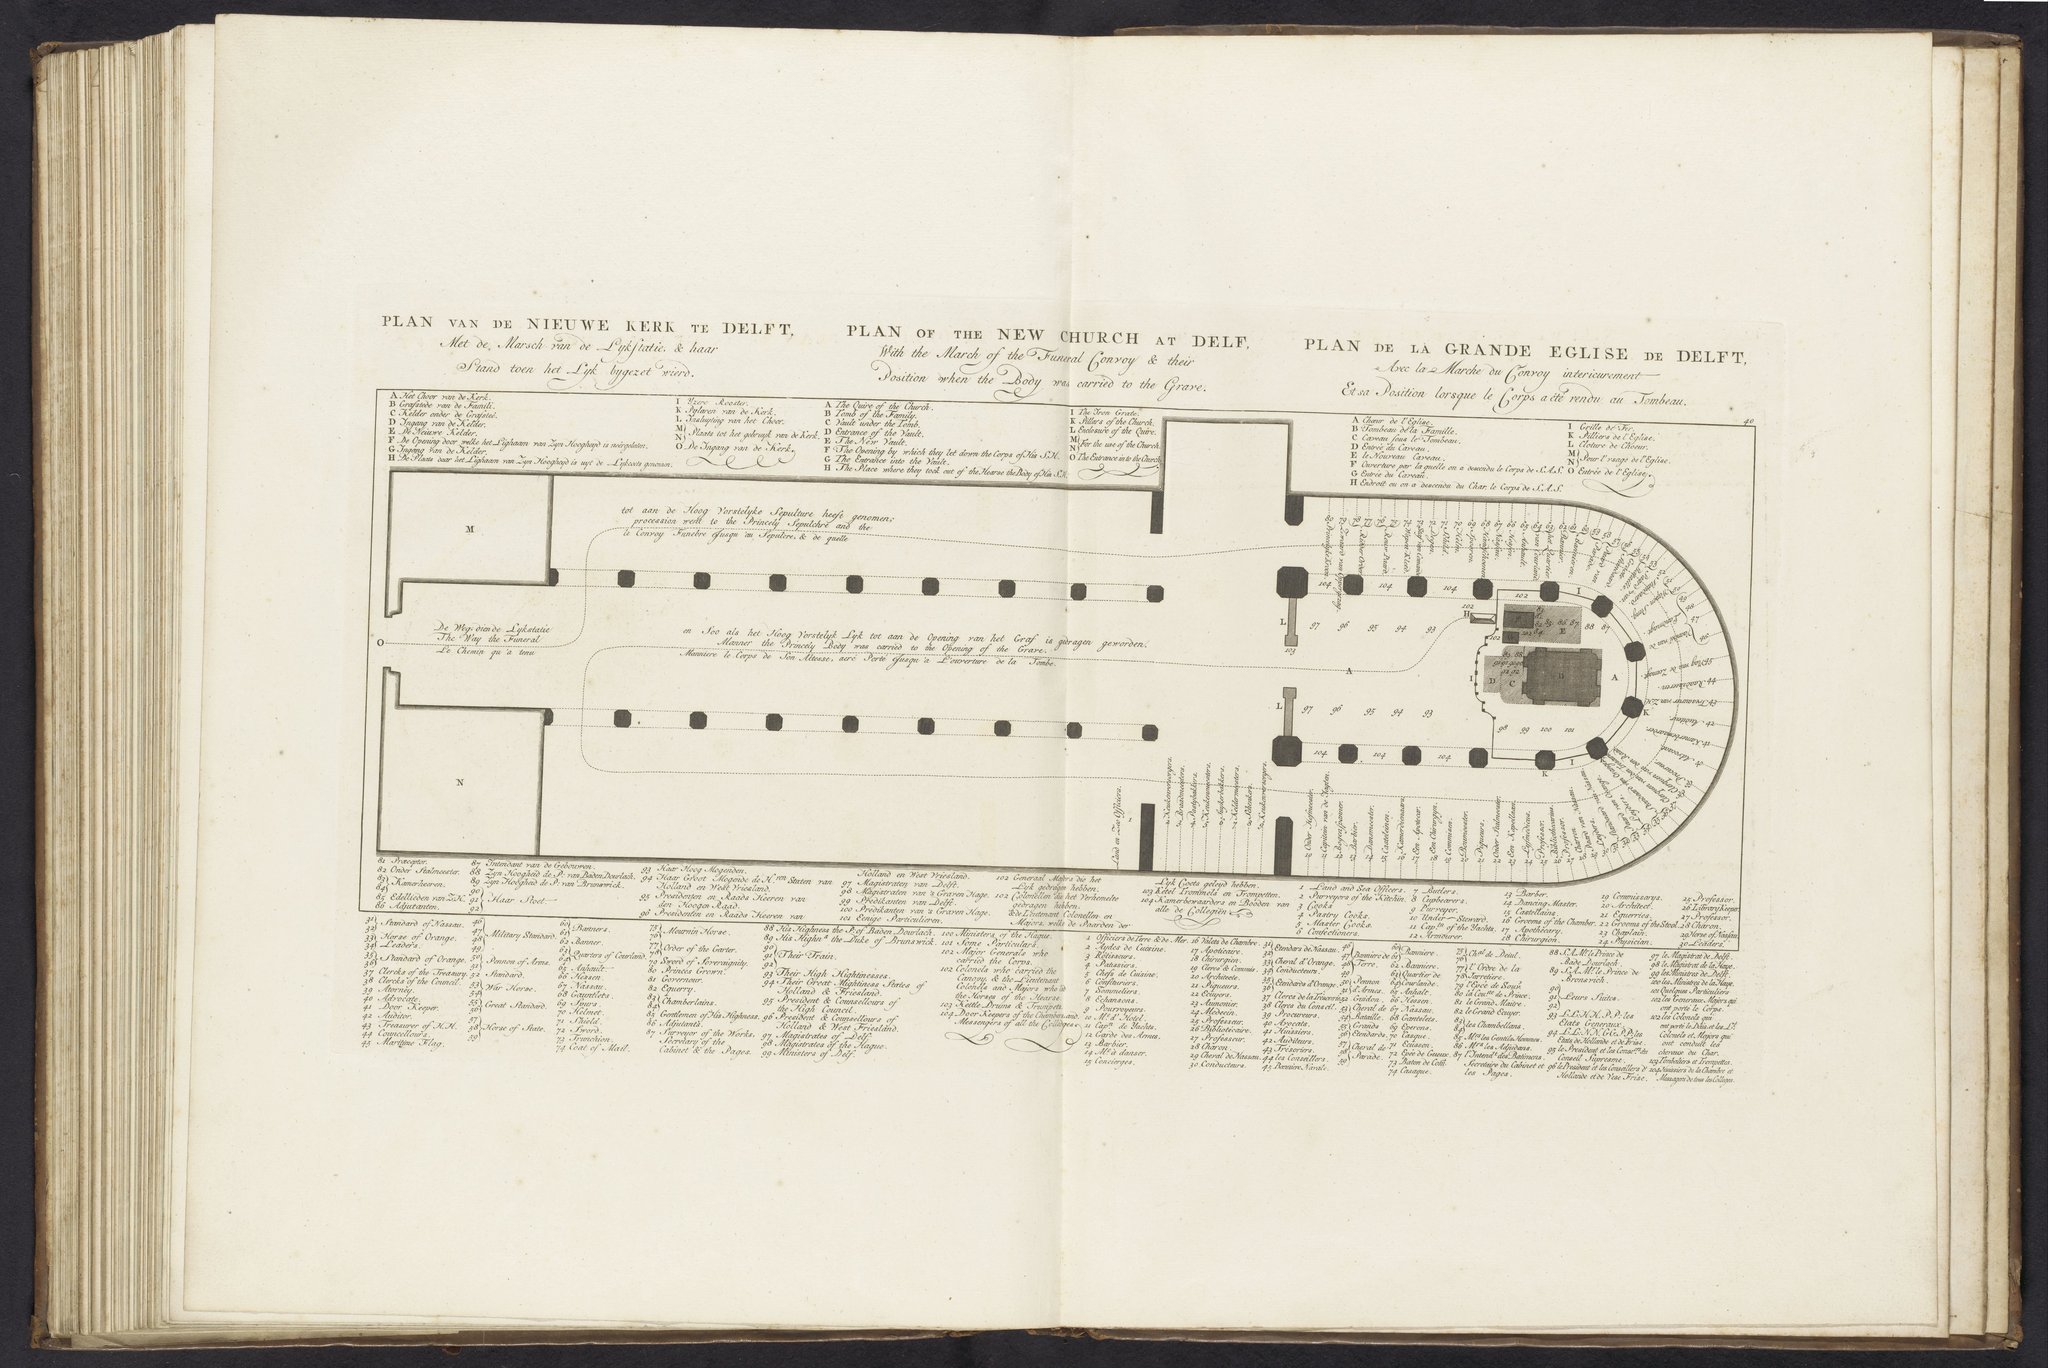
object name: print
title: Lijkstatie van Willem IV, 1752, plaat 40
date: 1754-1755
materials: paper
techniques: engraving, etching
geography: northern netherlands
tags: the hague, willem iv (prins van oranje-nassau), cortege, funeral procession, plan ~ architecture, delft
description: Plattegrond van de Nieuwe Kerk te Delft. In de marge het onderschrift in Nederlands, Frans en Engels met een overzicht van de plaatsen waar alle gasten hebben plaatsgenomen. Onderdeel van een serie van 41 platen van de begrafenisstoet van stadhouder Willem IV te Delft op 4 februari 1752. Genummerd rechtsboven: 40. In de gebonden uitgave van 1755.